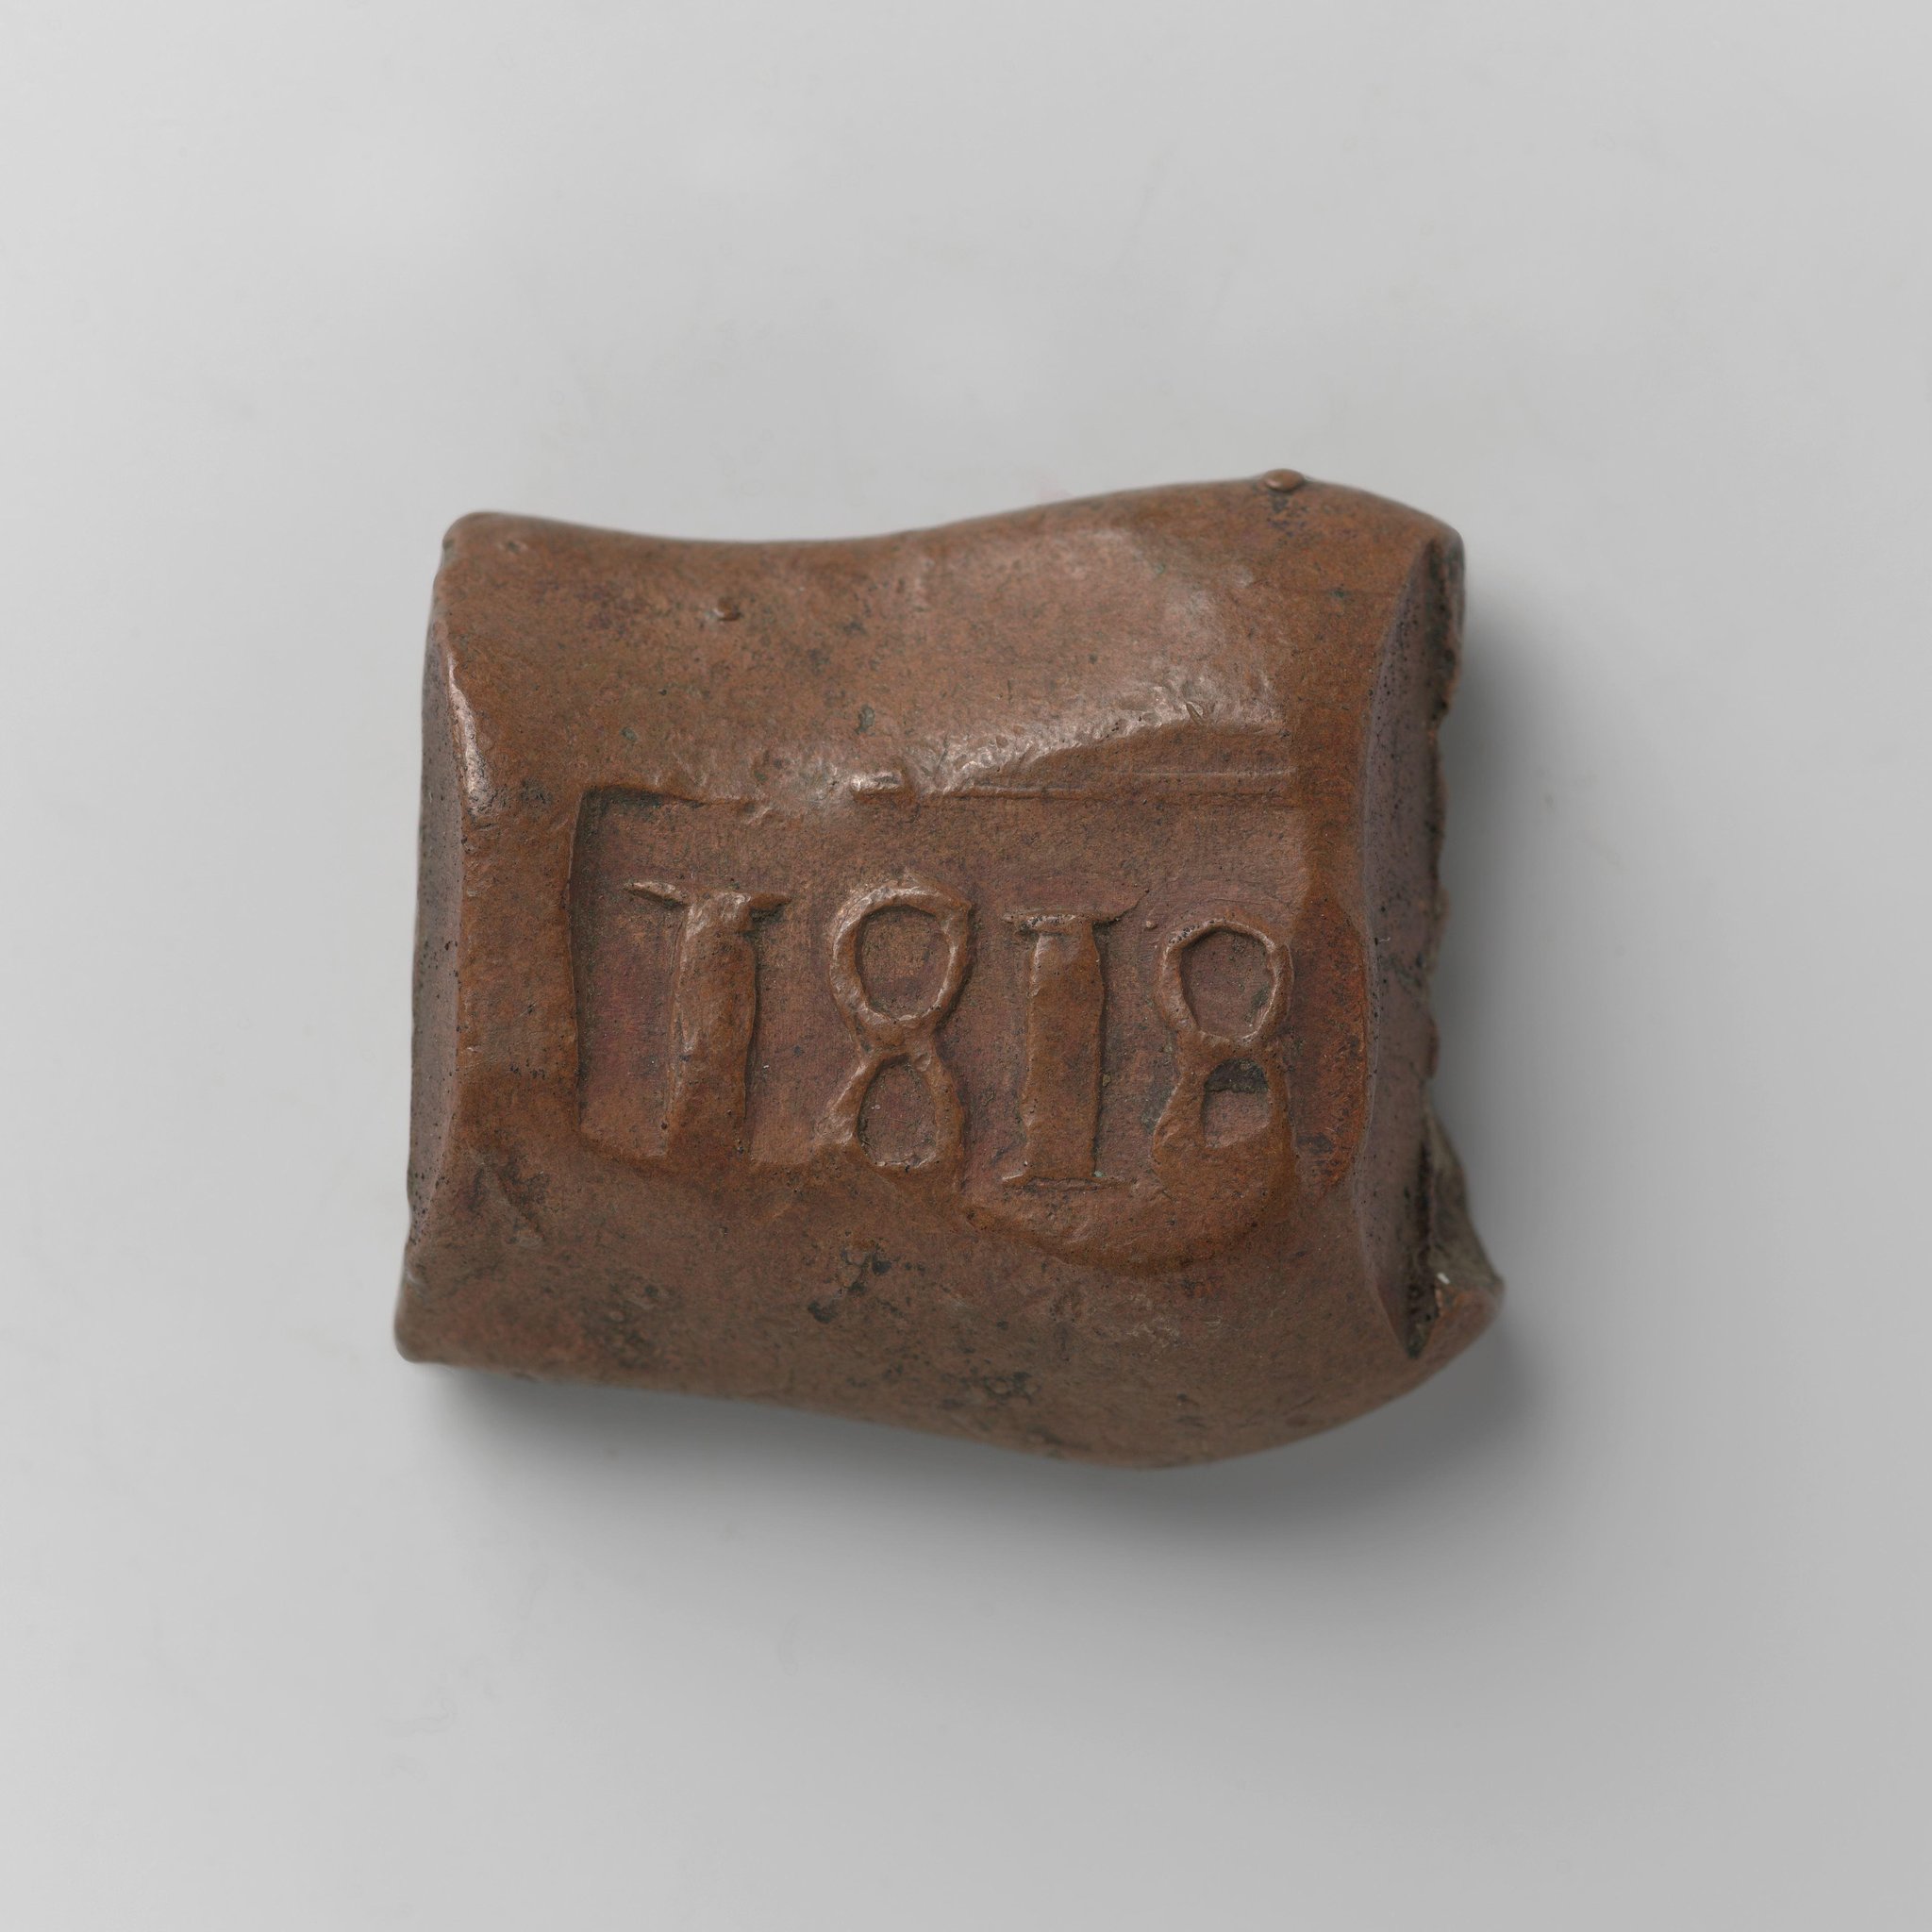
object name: coin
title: Nederlands Indië, 2 stuiver bonk,1818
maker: william i of the netherlands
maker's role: koning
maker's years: 1772-1843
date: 1818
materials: copper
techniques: striking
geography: surabaya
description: Koperen rechthoekige munt. Voorzijde: binnen een rechthoekige lijst waarde-aanduiding 2 St. Keerzijde: binnen een rechthoekige lijst jaartal.